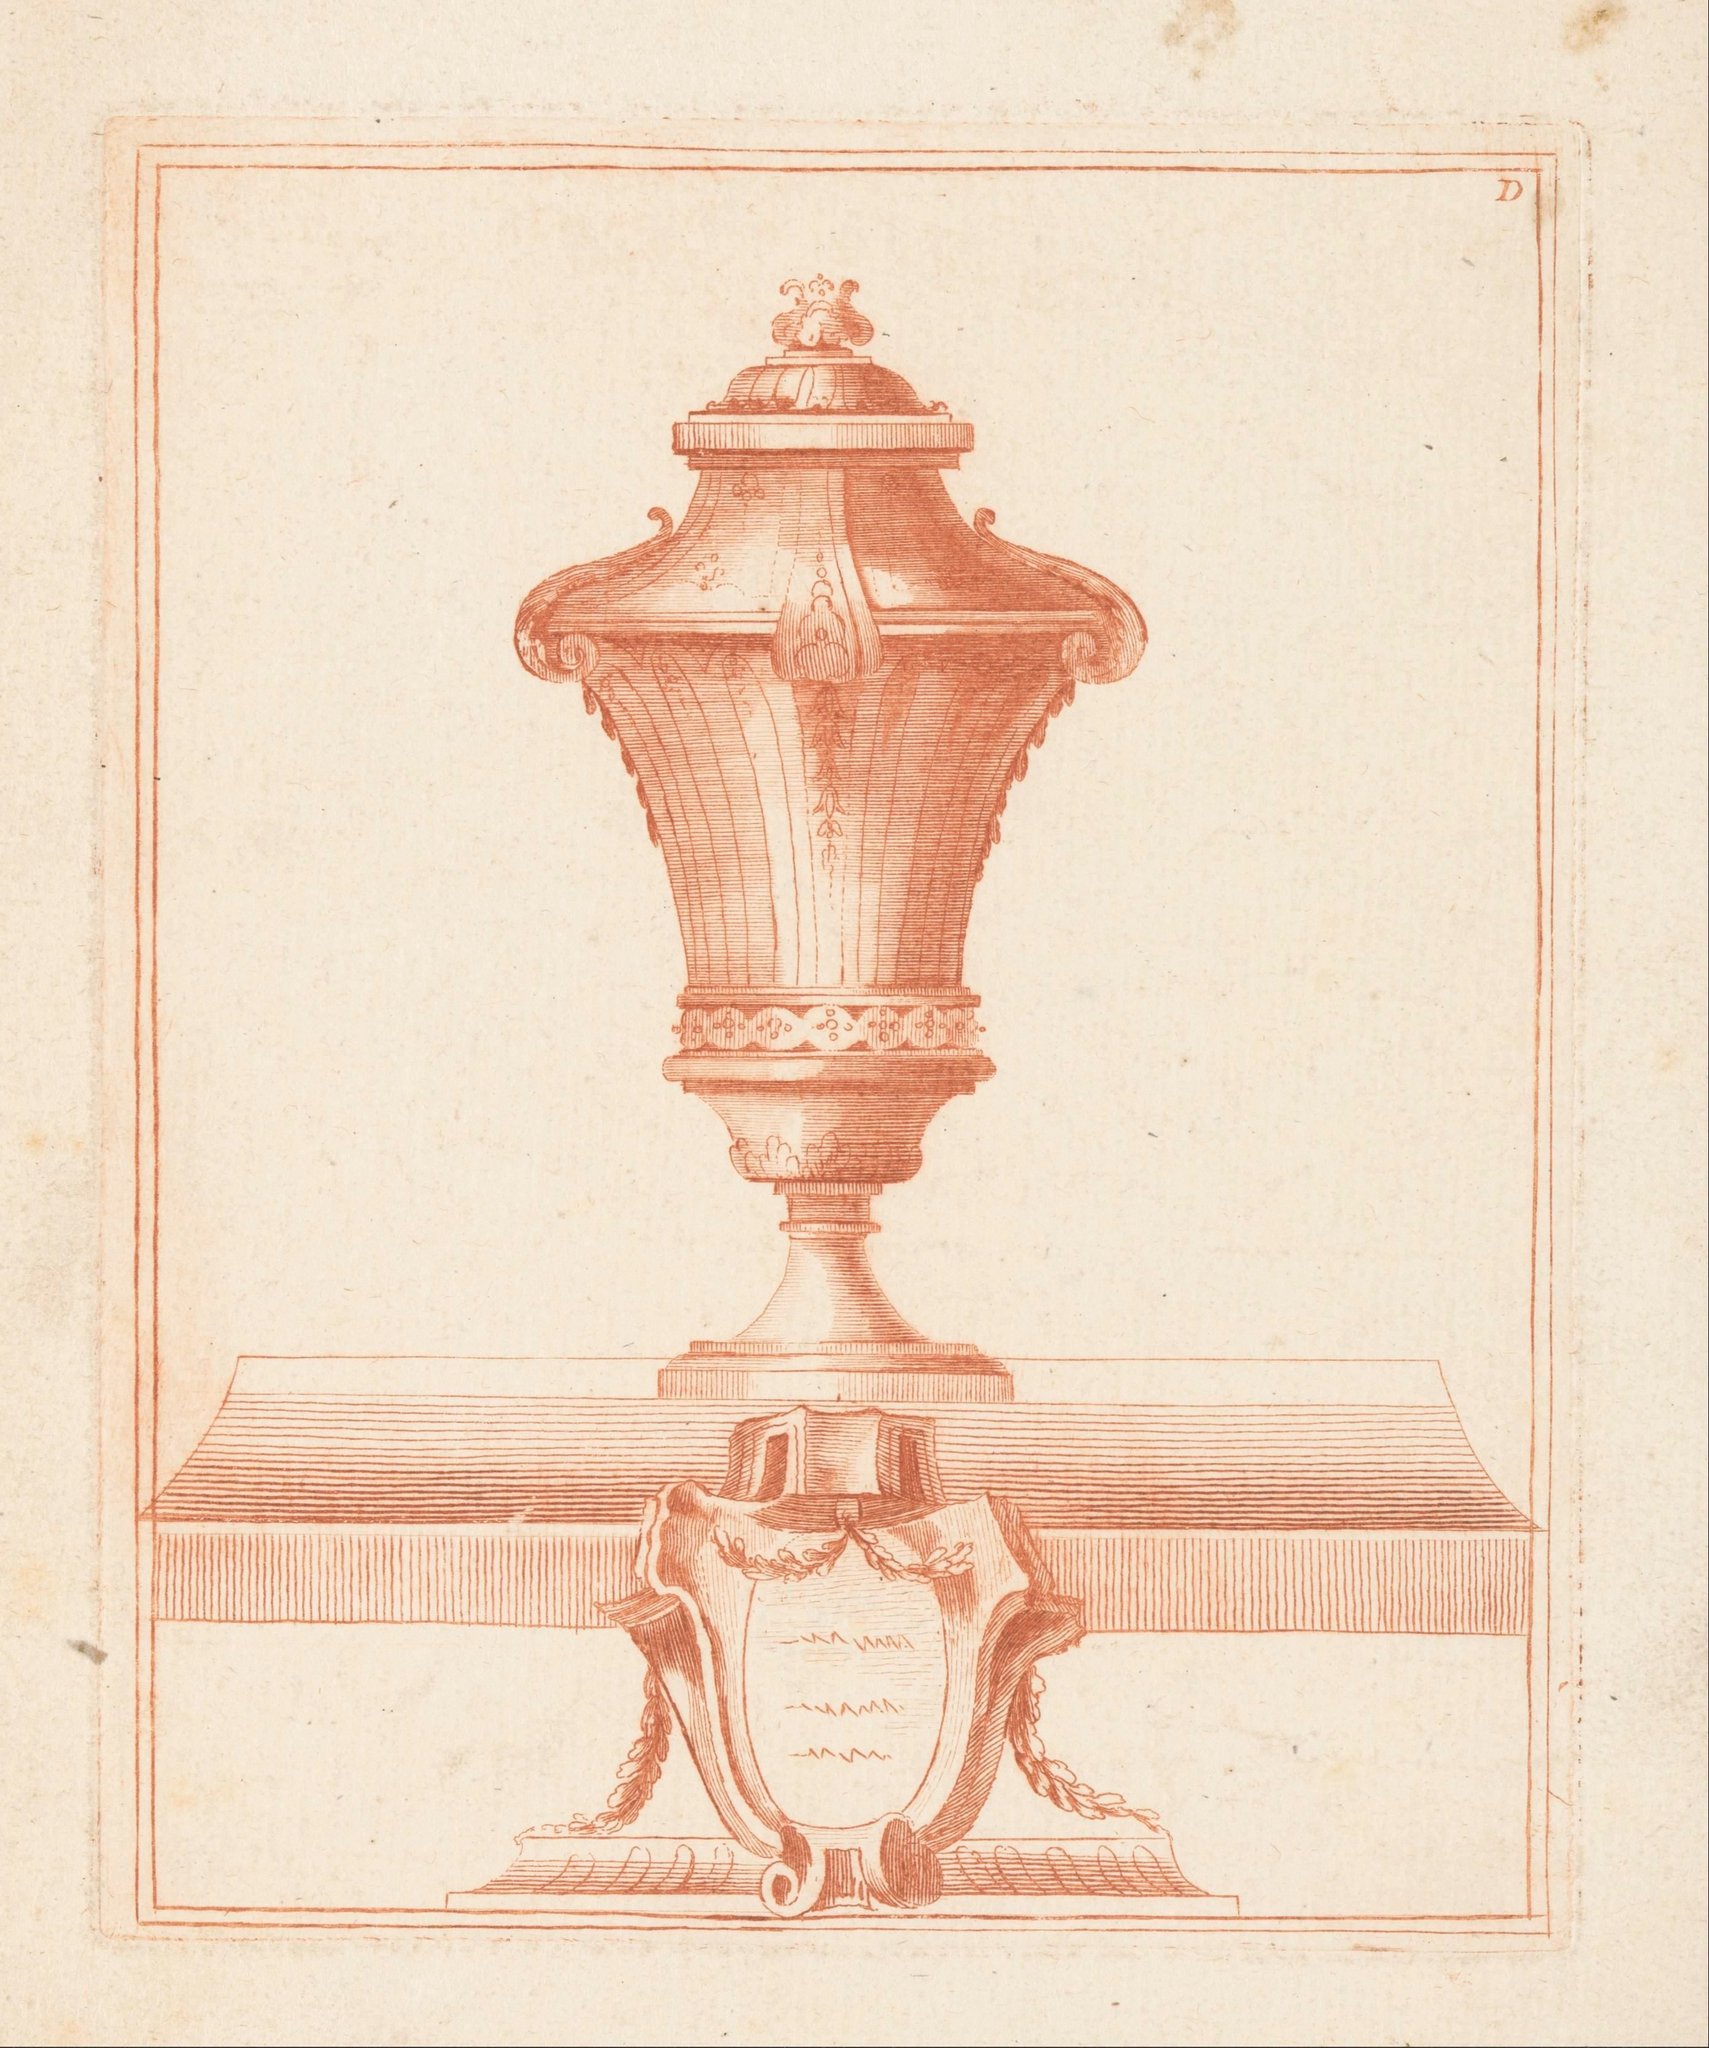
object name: ornament print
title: Vaas en cartouche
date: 1770-1780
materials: paper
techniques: etching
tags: vase ~ ornament, ornament ~ cartouche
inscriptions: collector's mark: Lugt 2228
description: Een geornamenteerde vaas, daaronder een cartouche met guirlande. Rechts boven D genummerd.